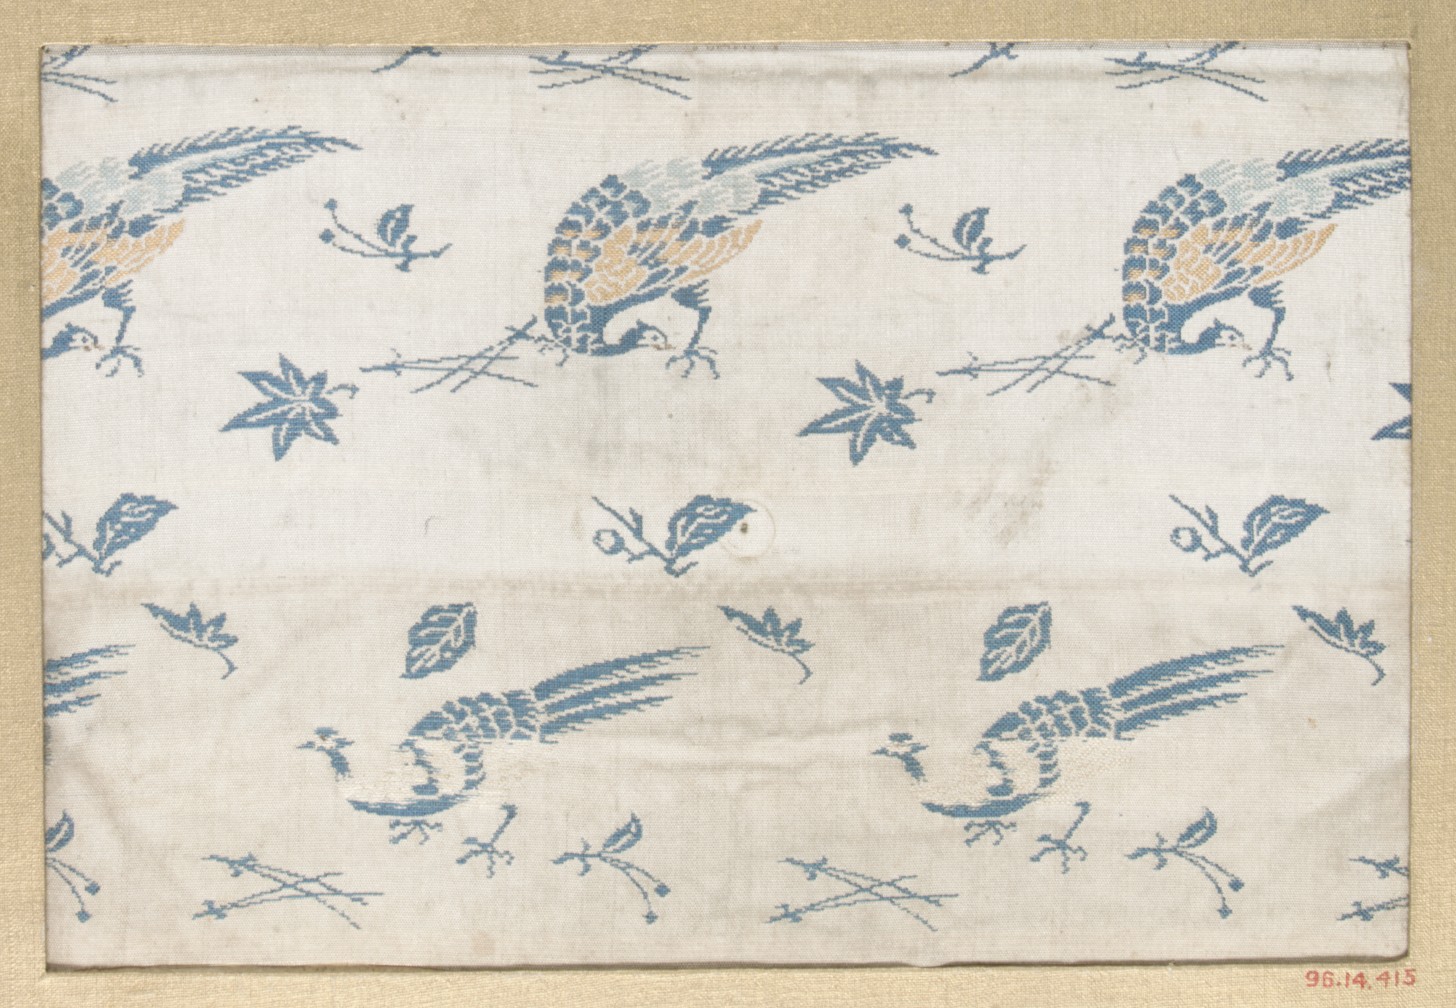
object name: piece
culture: japanese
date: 1701-1900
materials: silk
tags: leaves